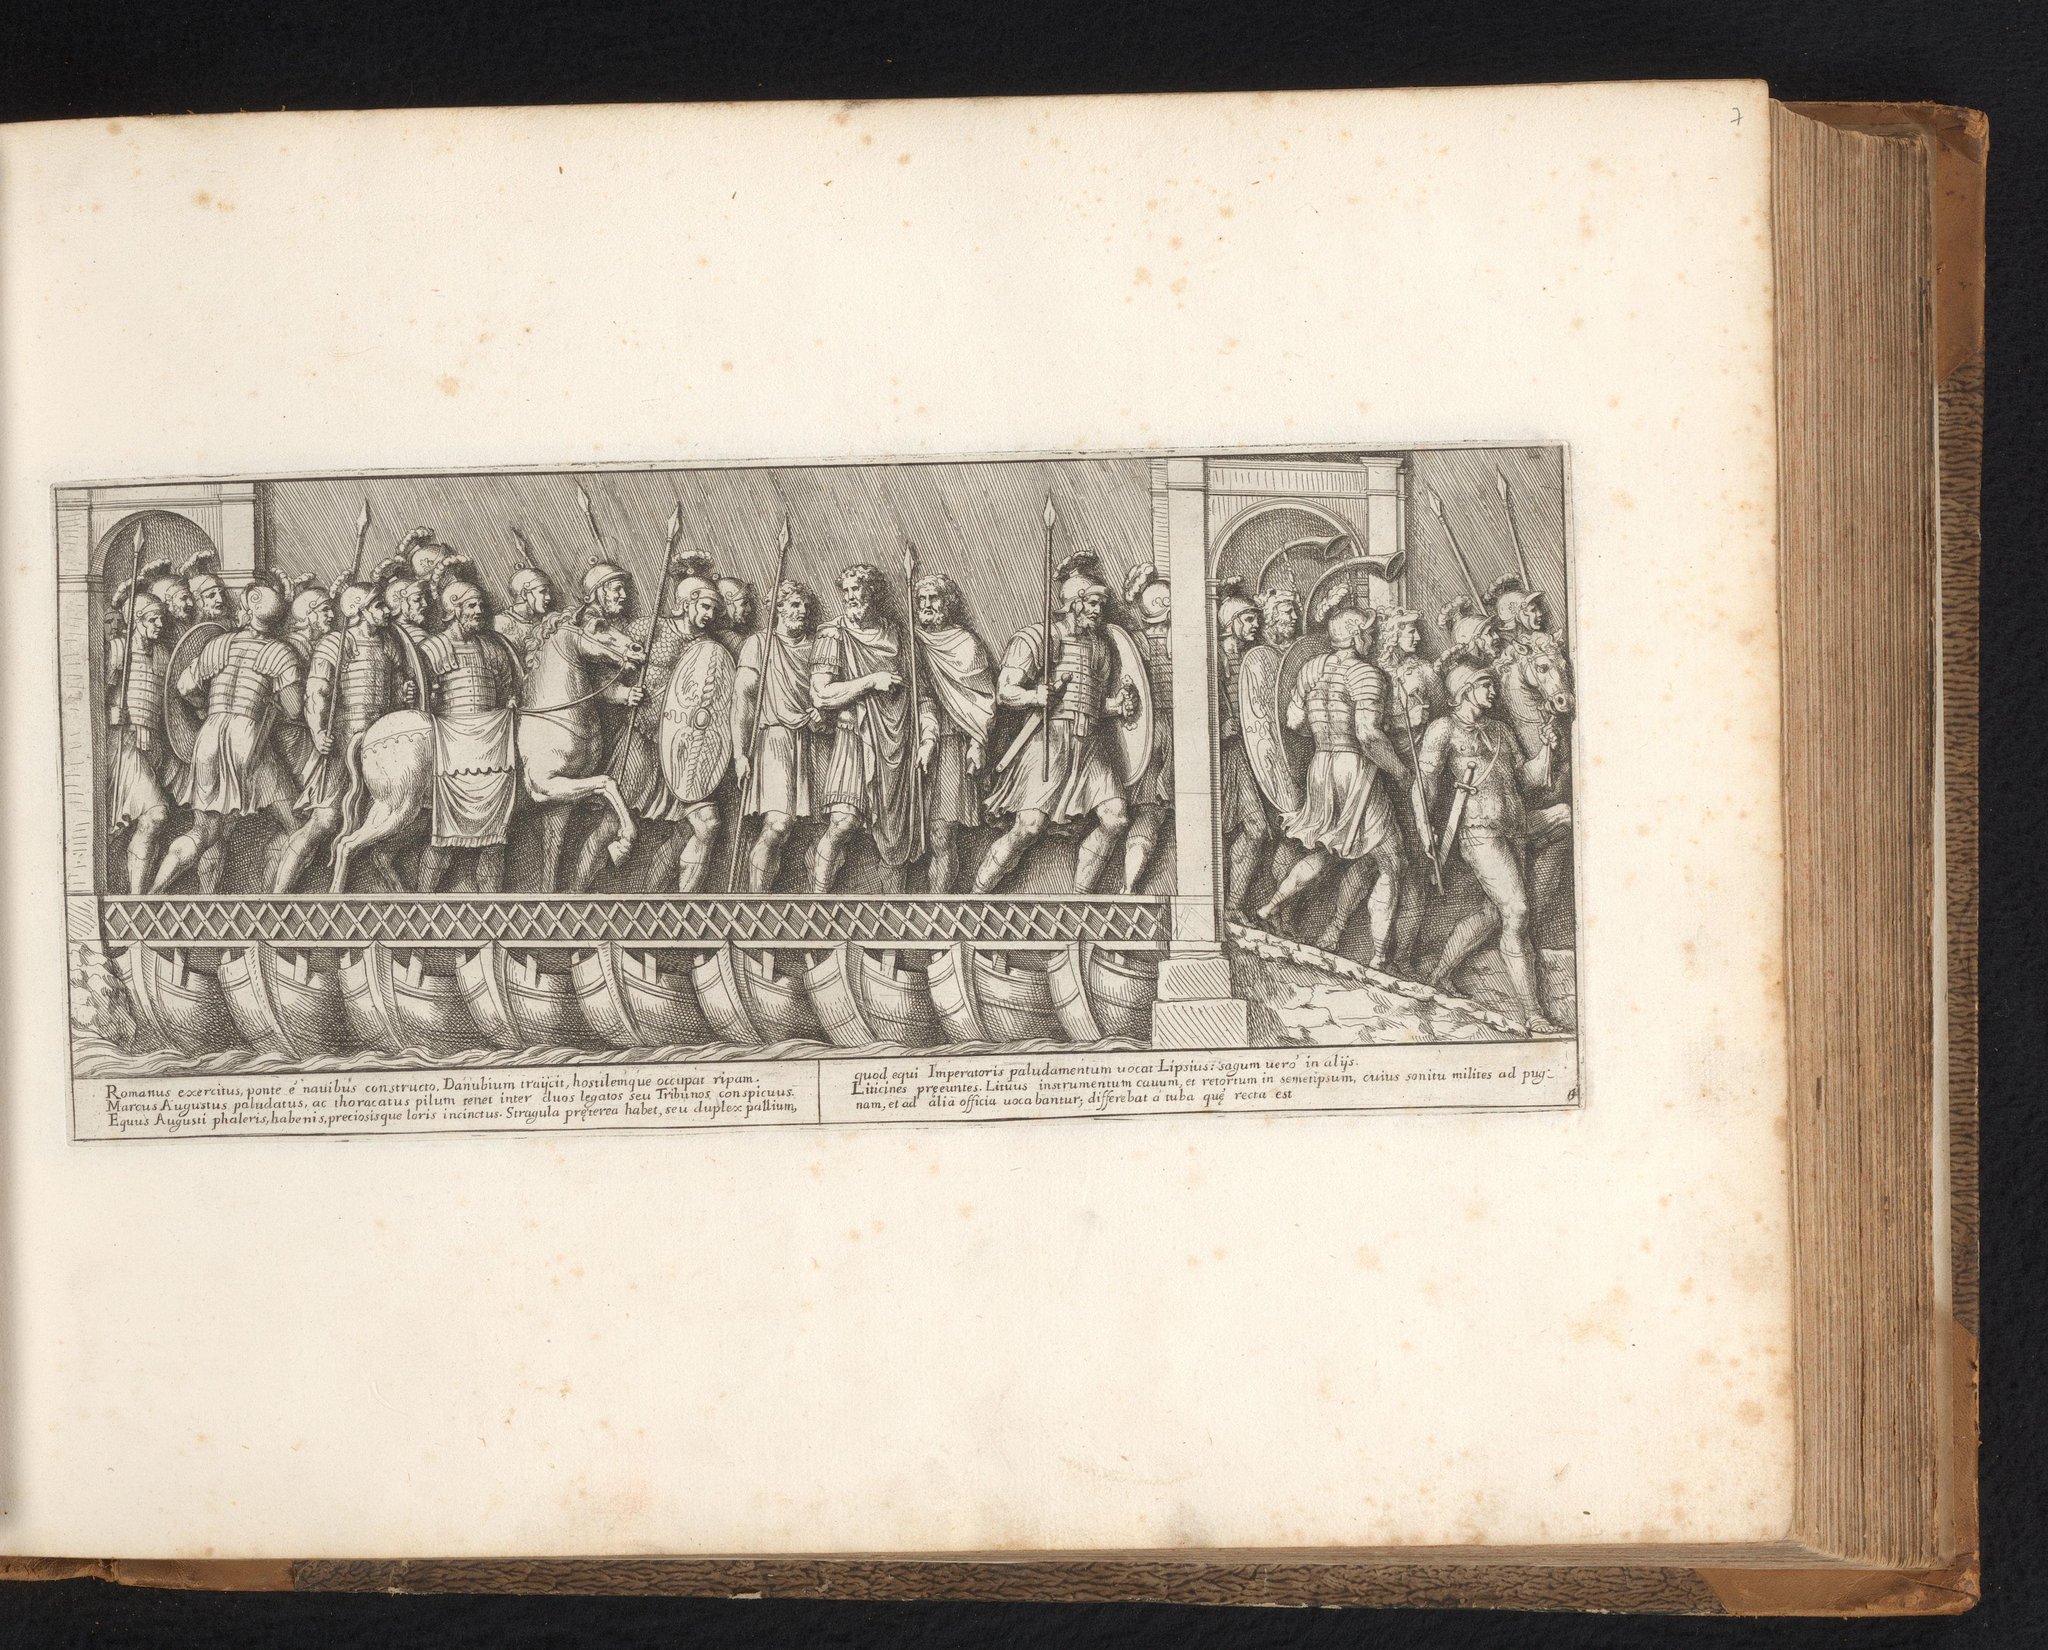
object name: print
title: Columna Antoniniana Marci Aurelii Antonini Augusti rebus gestis insignis (...)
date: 1672-1675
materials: paper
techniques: etching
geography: rome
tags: triumphal column with helical friezes, piece of sculpture, reproduction of a piece of sculpture, the soldier; the soldier's life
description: Detail van het spiraalvormige gebeeldhouwde fries op de Zuil van Marcus Aurelius te Rome. Het fries toont de oorlog tussen het Romeinse leger van keizer Marcus Aurelius en de Germaanse stammen der Marcomannen en Quaden en de oorlog tegen de Sarmaten die vanuit het huidige Iran Hongarije waren binnengevallen. Tekst in de ondermarge. Prent maakt deel uit van een album.